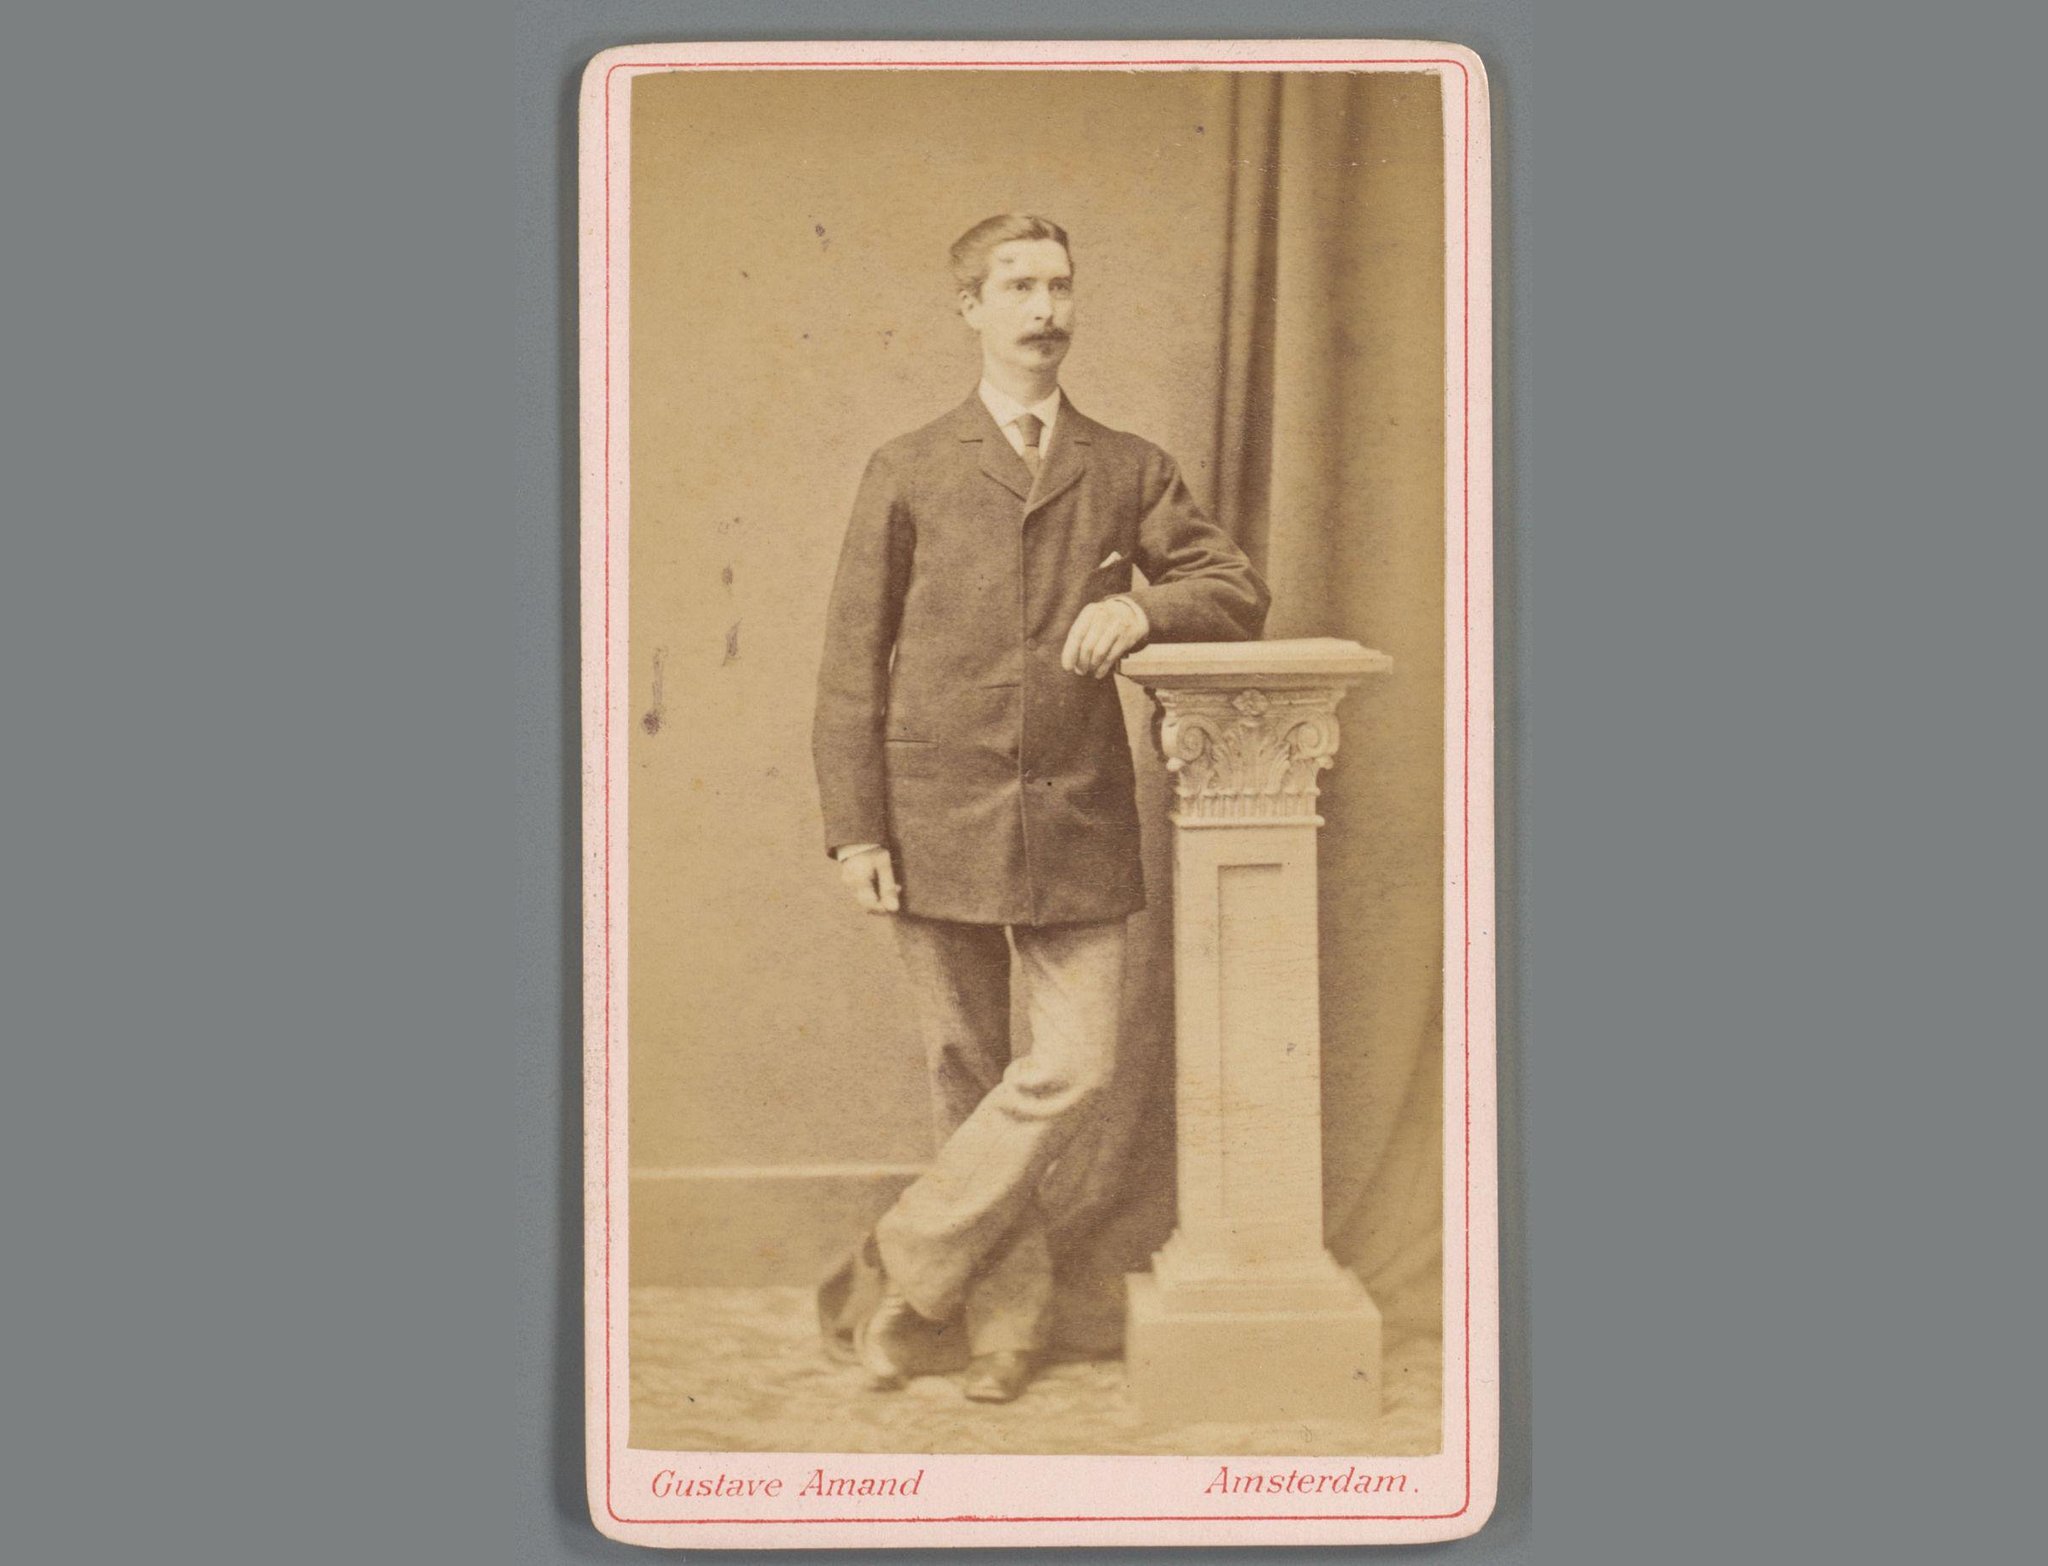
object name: carte de visite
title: Portret van een onbekende man uit de familie en de kring van Eugene van Delden en Belle van Delden-Denninghof Stelling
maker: gustaaf leonardus adolf amand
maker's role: print maker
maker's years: 1833-1897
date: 1881-1889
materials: cardboard, paper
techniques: albumen print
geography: amsterdam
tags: historical persons not known by name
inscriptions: inscription: ‘Photographie Artistique./ Gustave Amand/ Warmoesstraat 147. Amsterdam.’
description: Portret uit de kring van Eugene van Delden (Hartapoera, 1865 - Den Haag, 1954) en Belle van Delden-Denninghof Stelling (Batavia, 1870 - Den Haag, 1947).